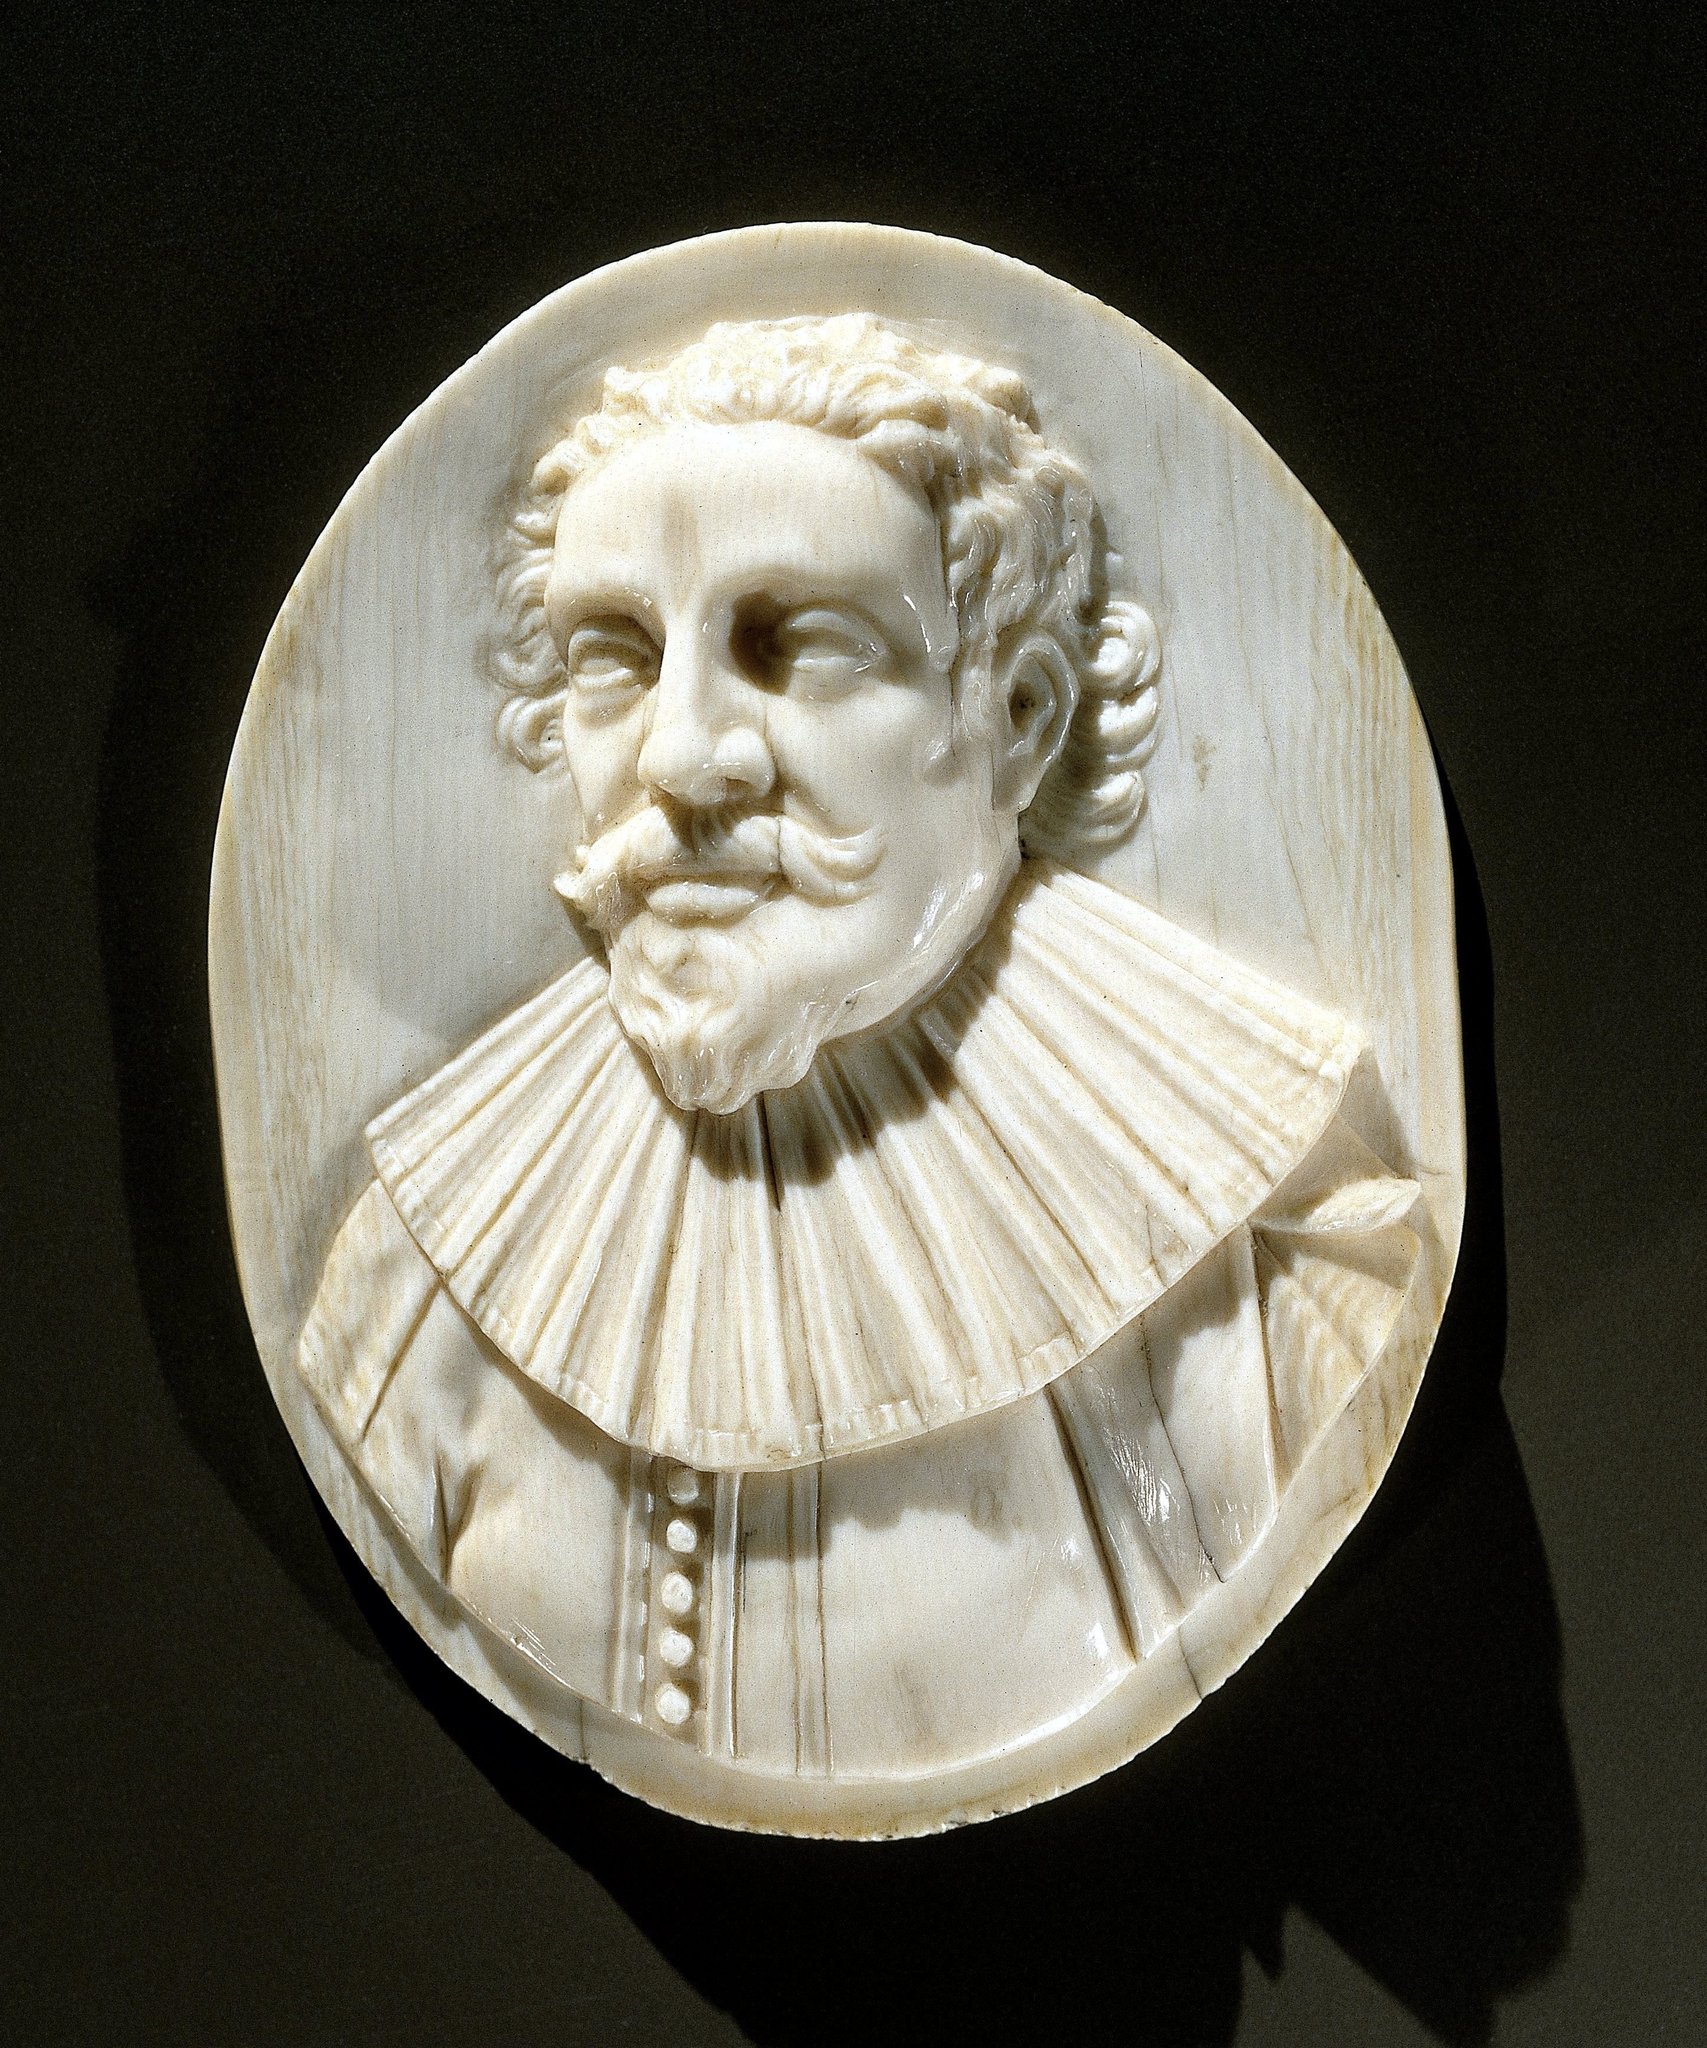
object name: relief sculpture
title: Portrait Medallion of Hugo Grotius (1583-1645)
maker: Anonymous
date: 1735-1750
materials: ivory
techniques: cutting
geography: netherlands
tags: delft, hugo de groot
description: Ovaal medaillon met mansportret (Hugo de Groot), borstbeeld naar rechts, in hoogreliëf. Hij heeft golvende haren, snor en sik. Hij draagt een buis met knoopjes en platte kraag. Keerzijde heeft over bijna gehele hoogte een spitstoelopende halfronde uitsparing. De uitsparing is bruin van kleur.